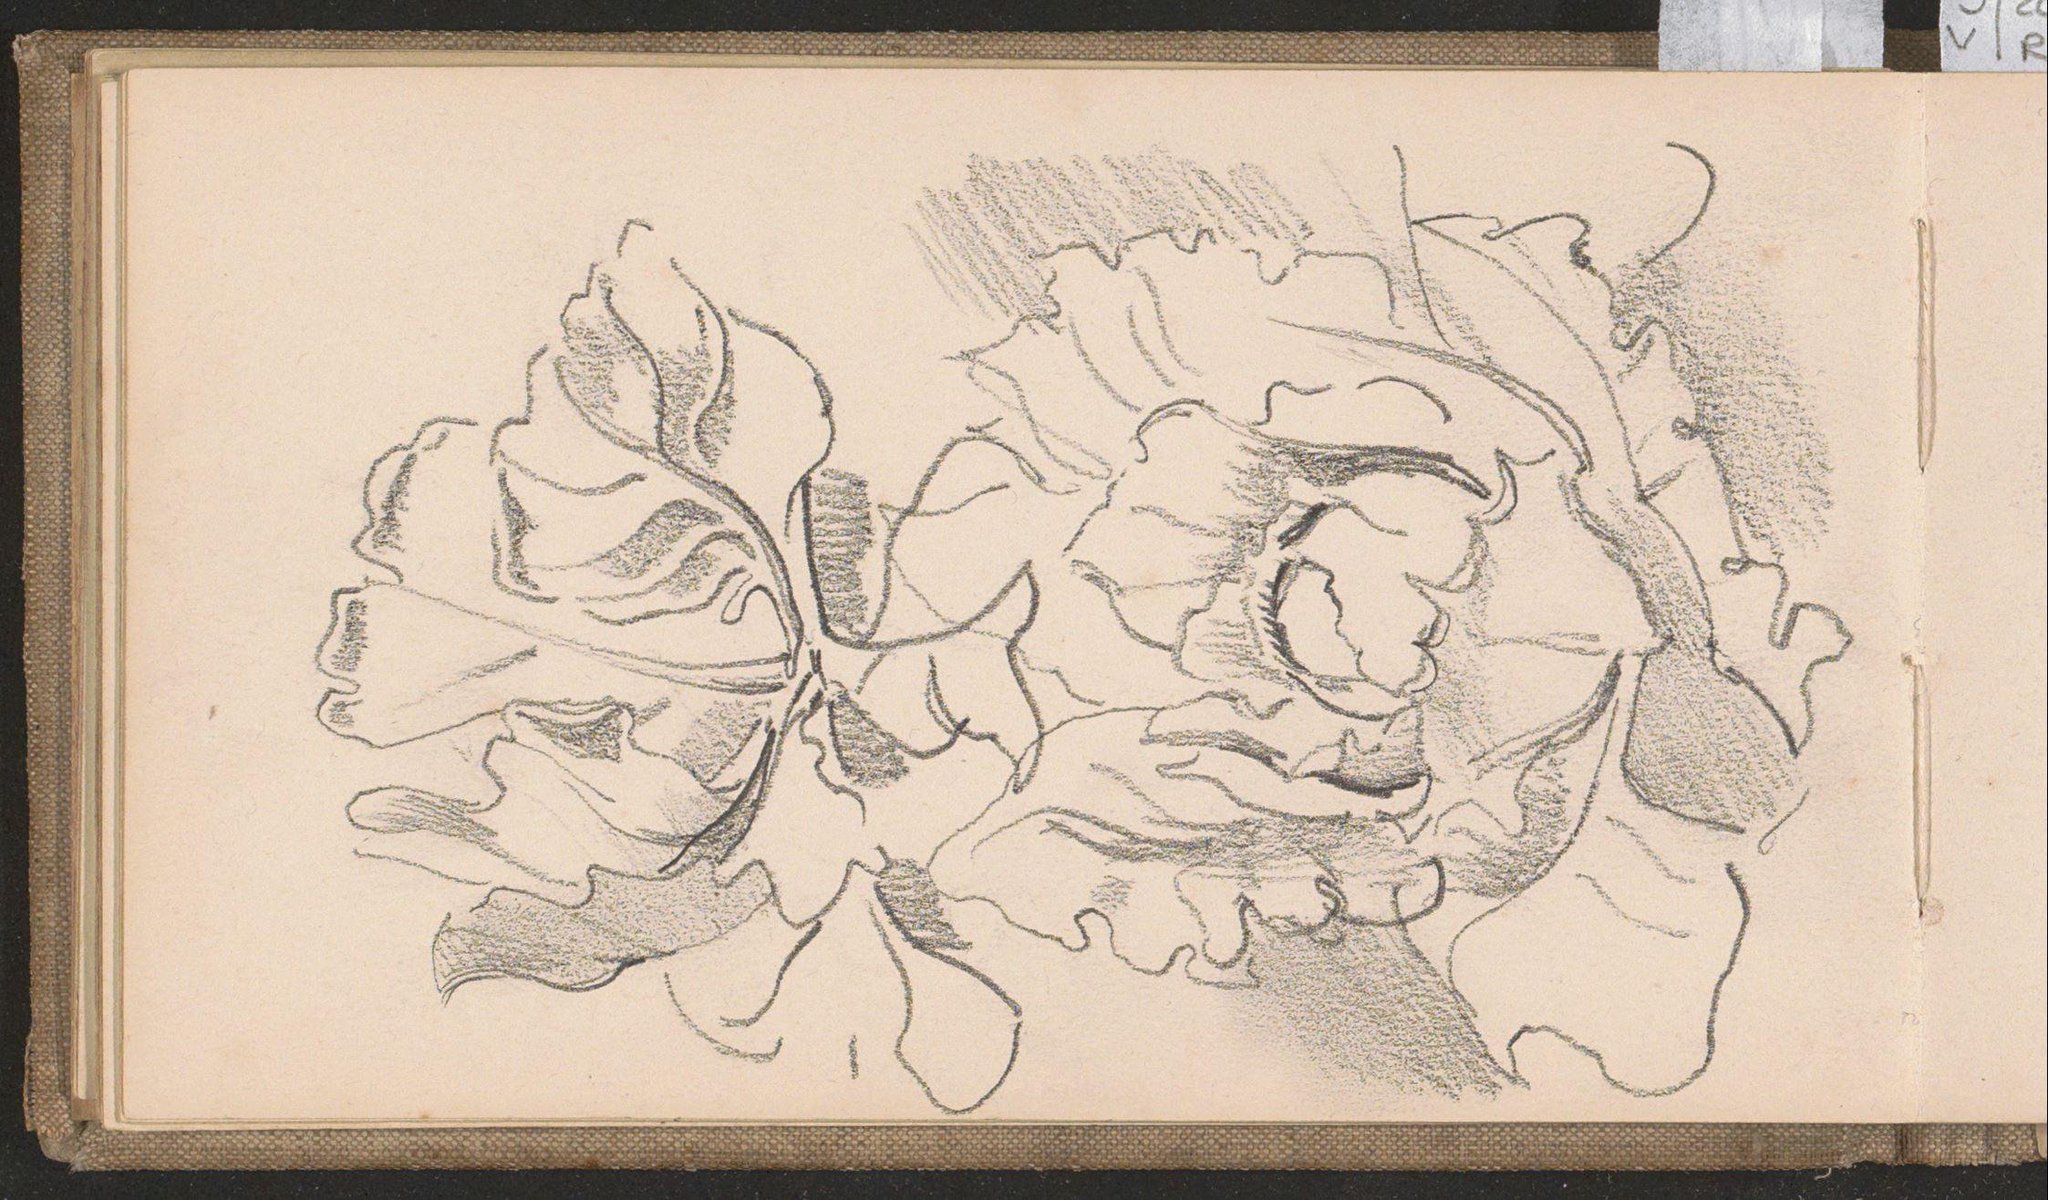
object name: sketchbook leaf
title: Bloemen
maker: antoon derkinderen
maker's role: draughtsman, painter, print maker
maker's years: 1859-1925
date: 1892-1901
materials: paper, pencil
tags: flowers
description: Blad 15 verso uit een schetsboek met 51 bladen.